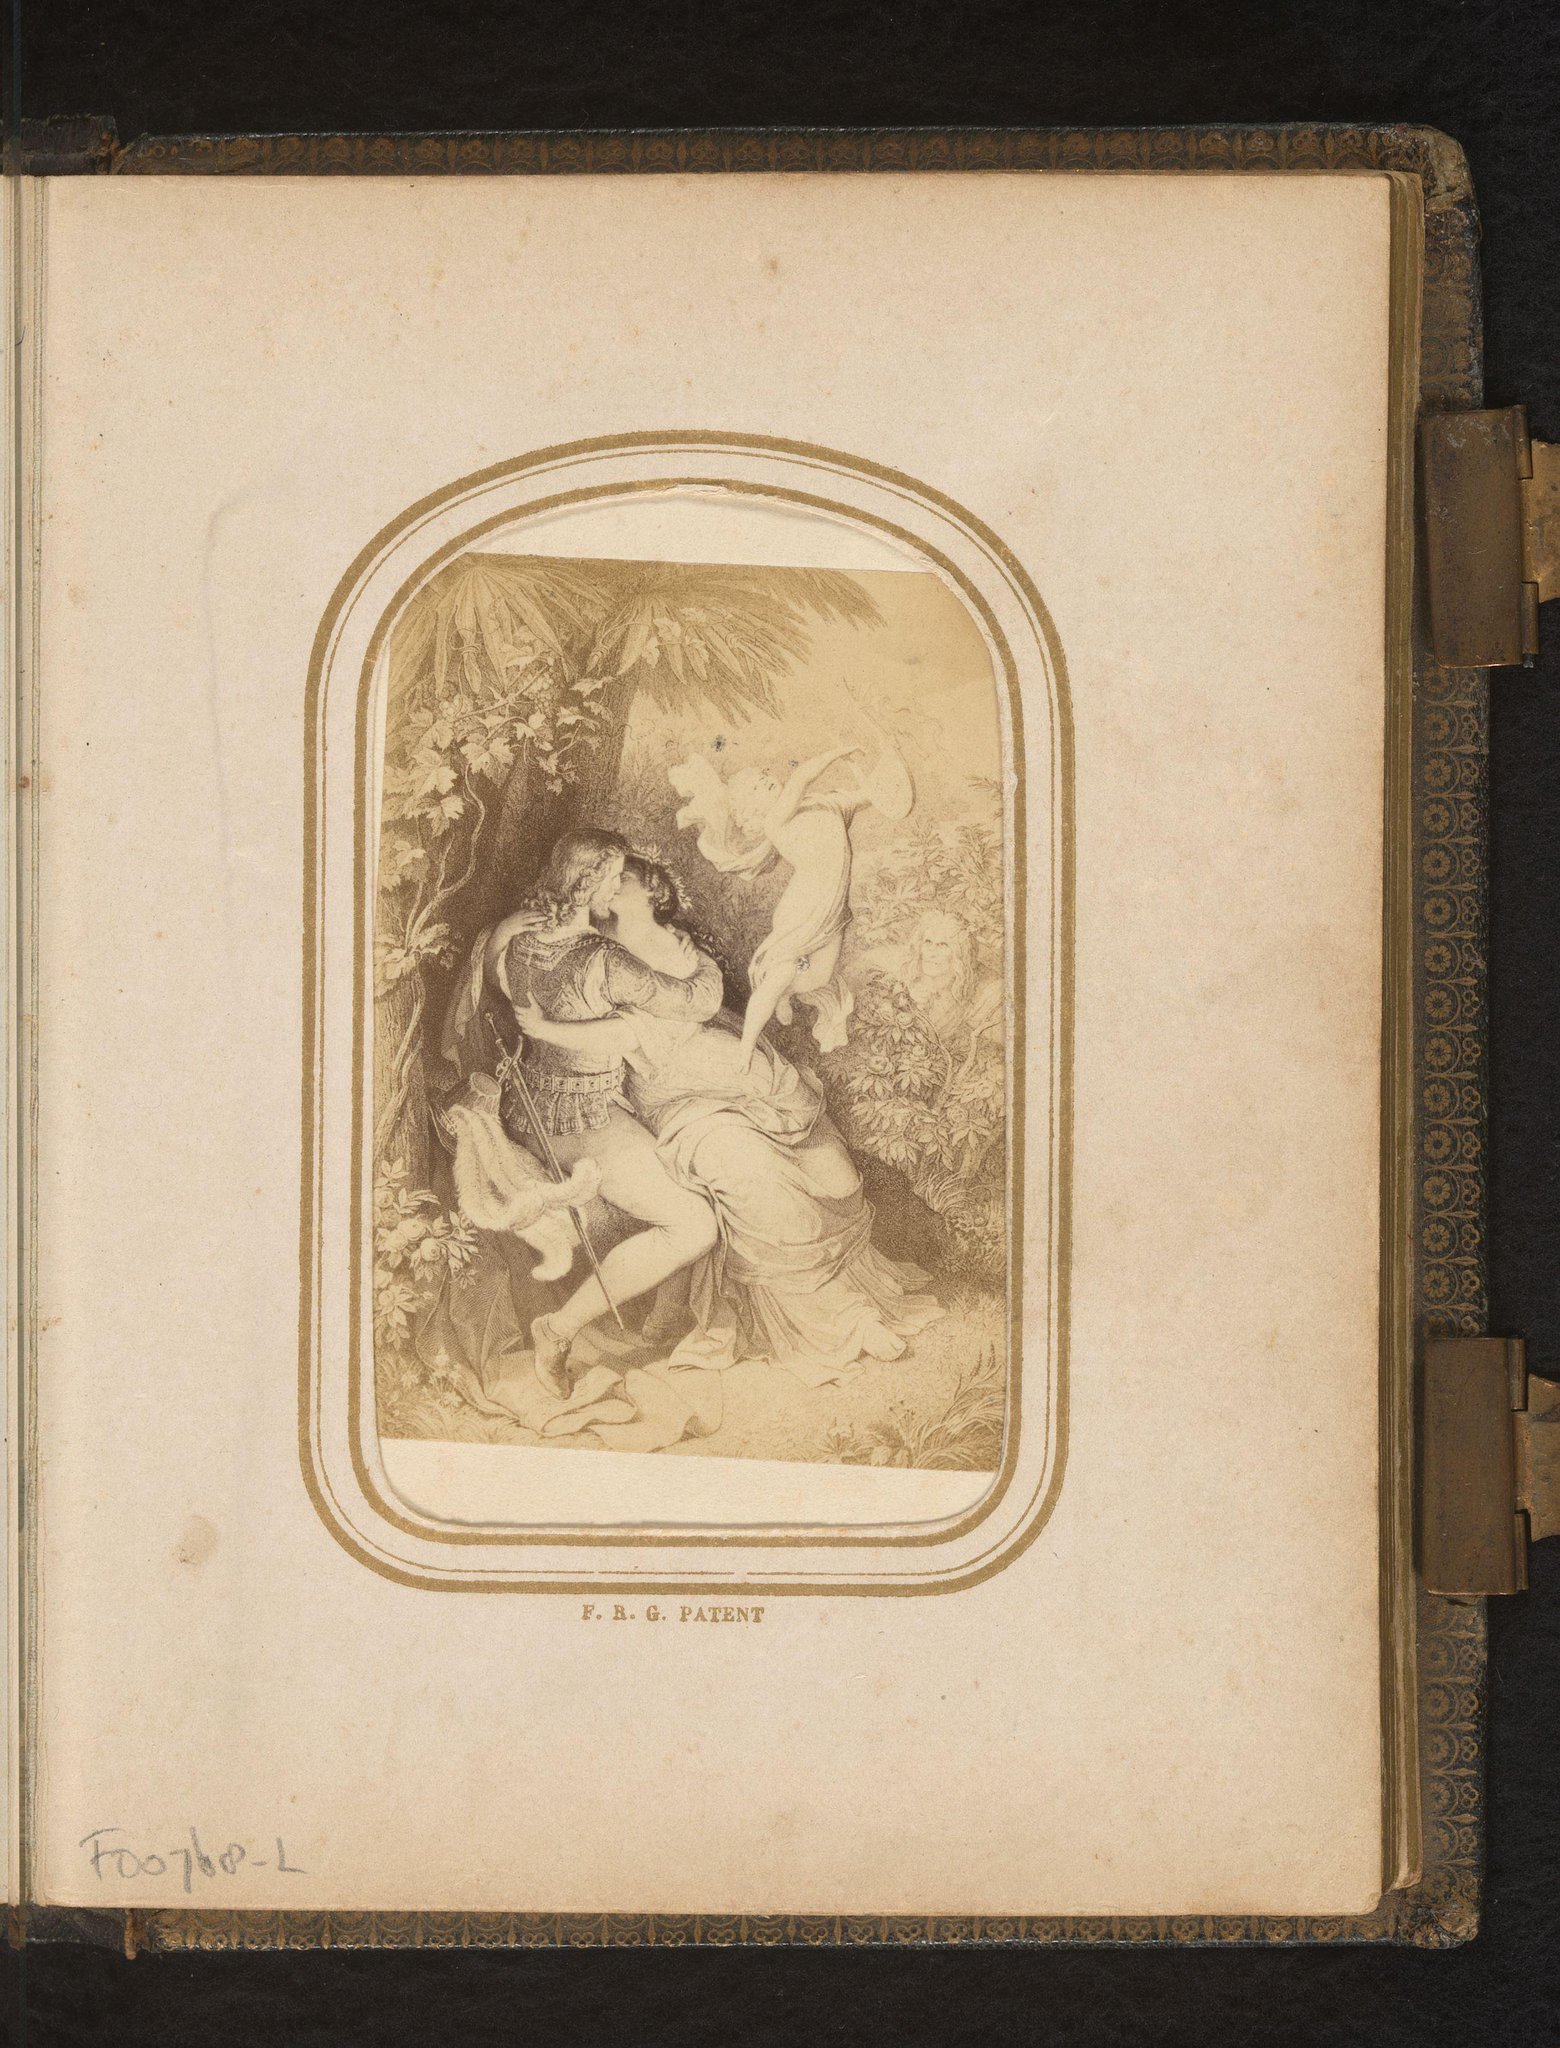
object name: reproduction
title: Helena (Faust)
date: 1865-1890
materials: cardboard, photographic support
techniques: albumen print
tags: cherubs, i.e. children's heads with wings, embracing each other, kissing, painting, drawing and the graphic arts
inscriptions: inscription: ‘A. Jager/ Water 110/ Amsterdam’